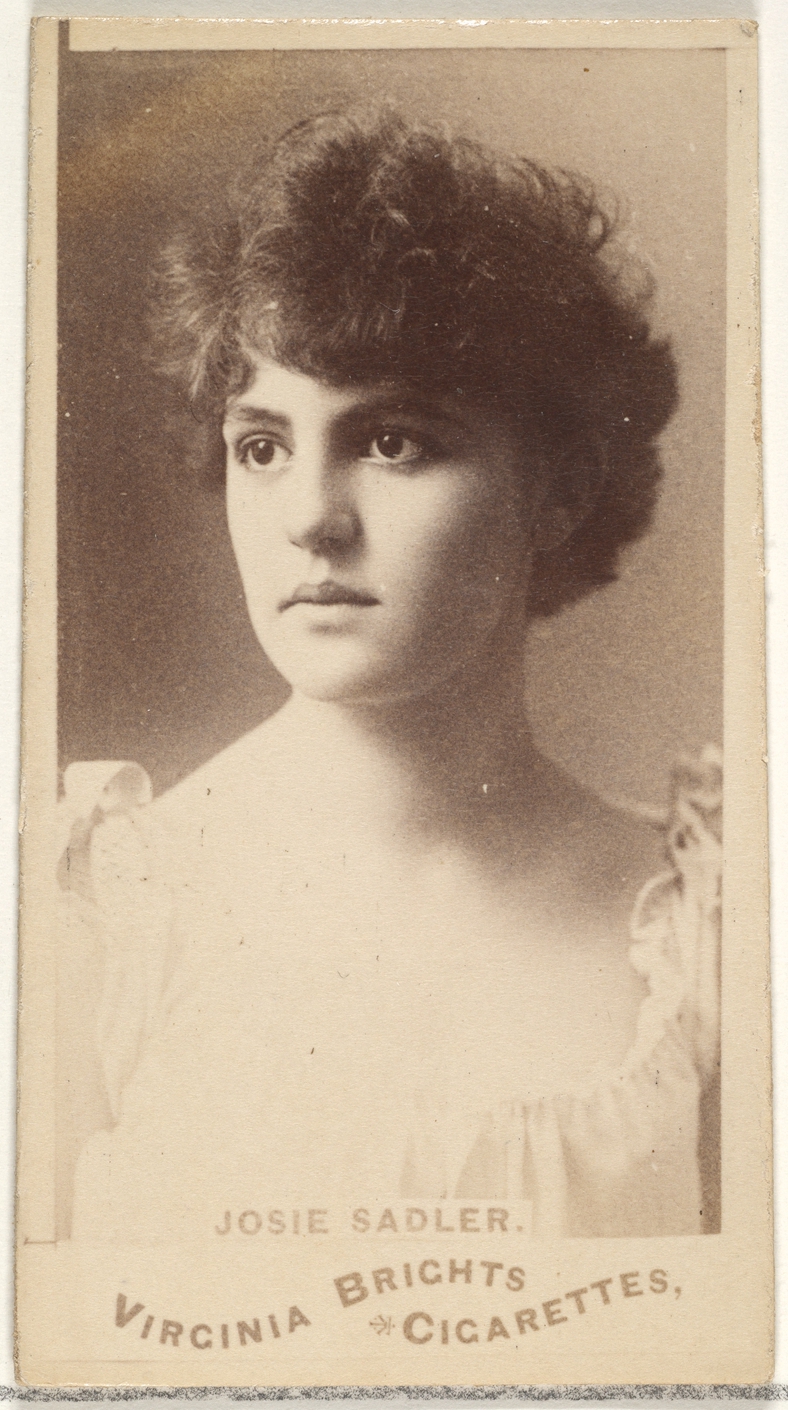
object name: photograph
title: Josie Sadler, from the Actors and Actresses series (N45, Type 1) for Virginia Brights Cigarettes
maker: allen & ginter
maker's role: publisher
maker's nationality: american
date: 1888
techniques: albumen silver print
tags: portraits,women,actresses